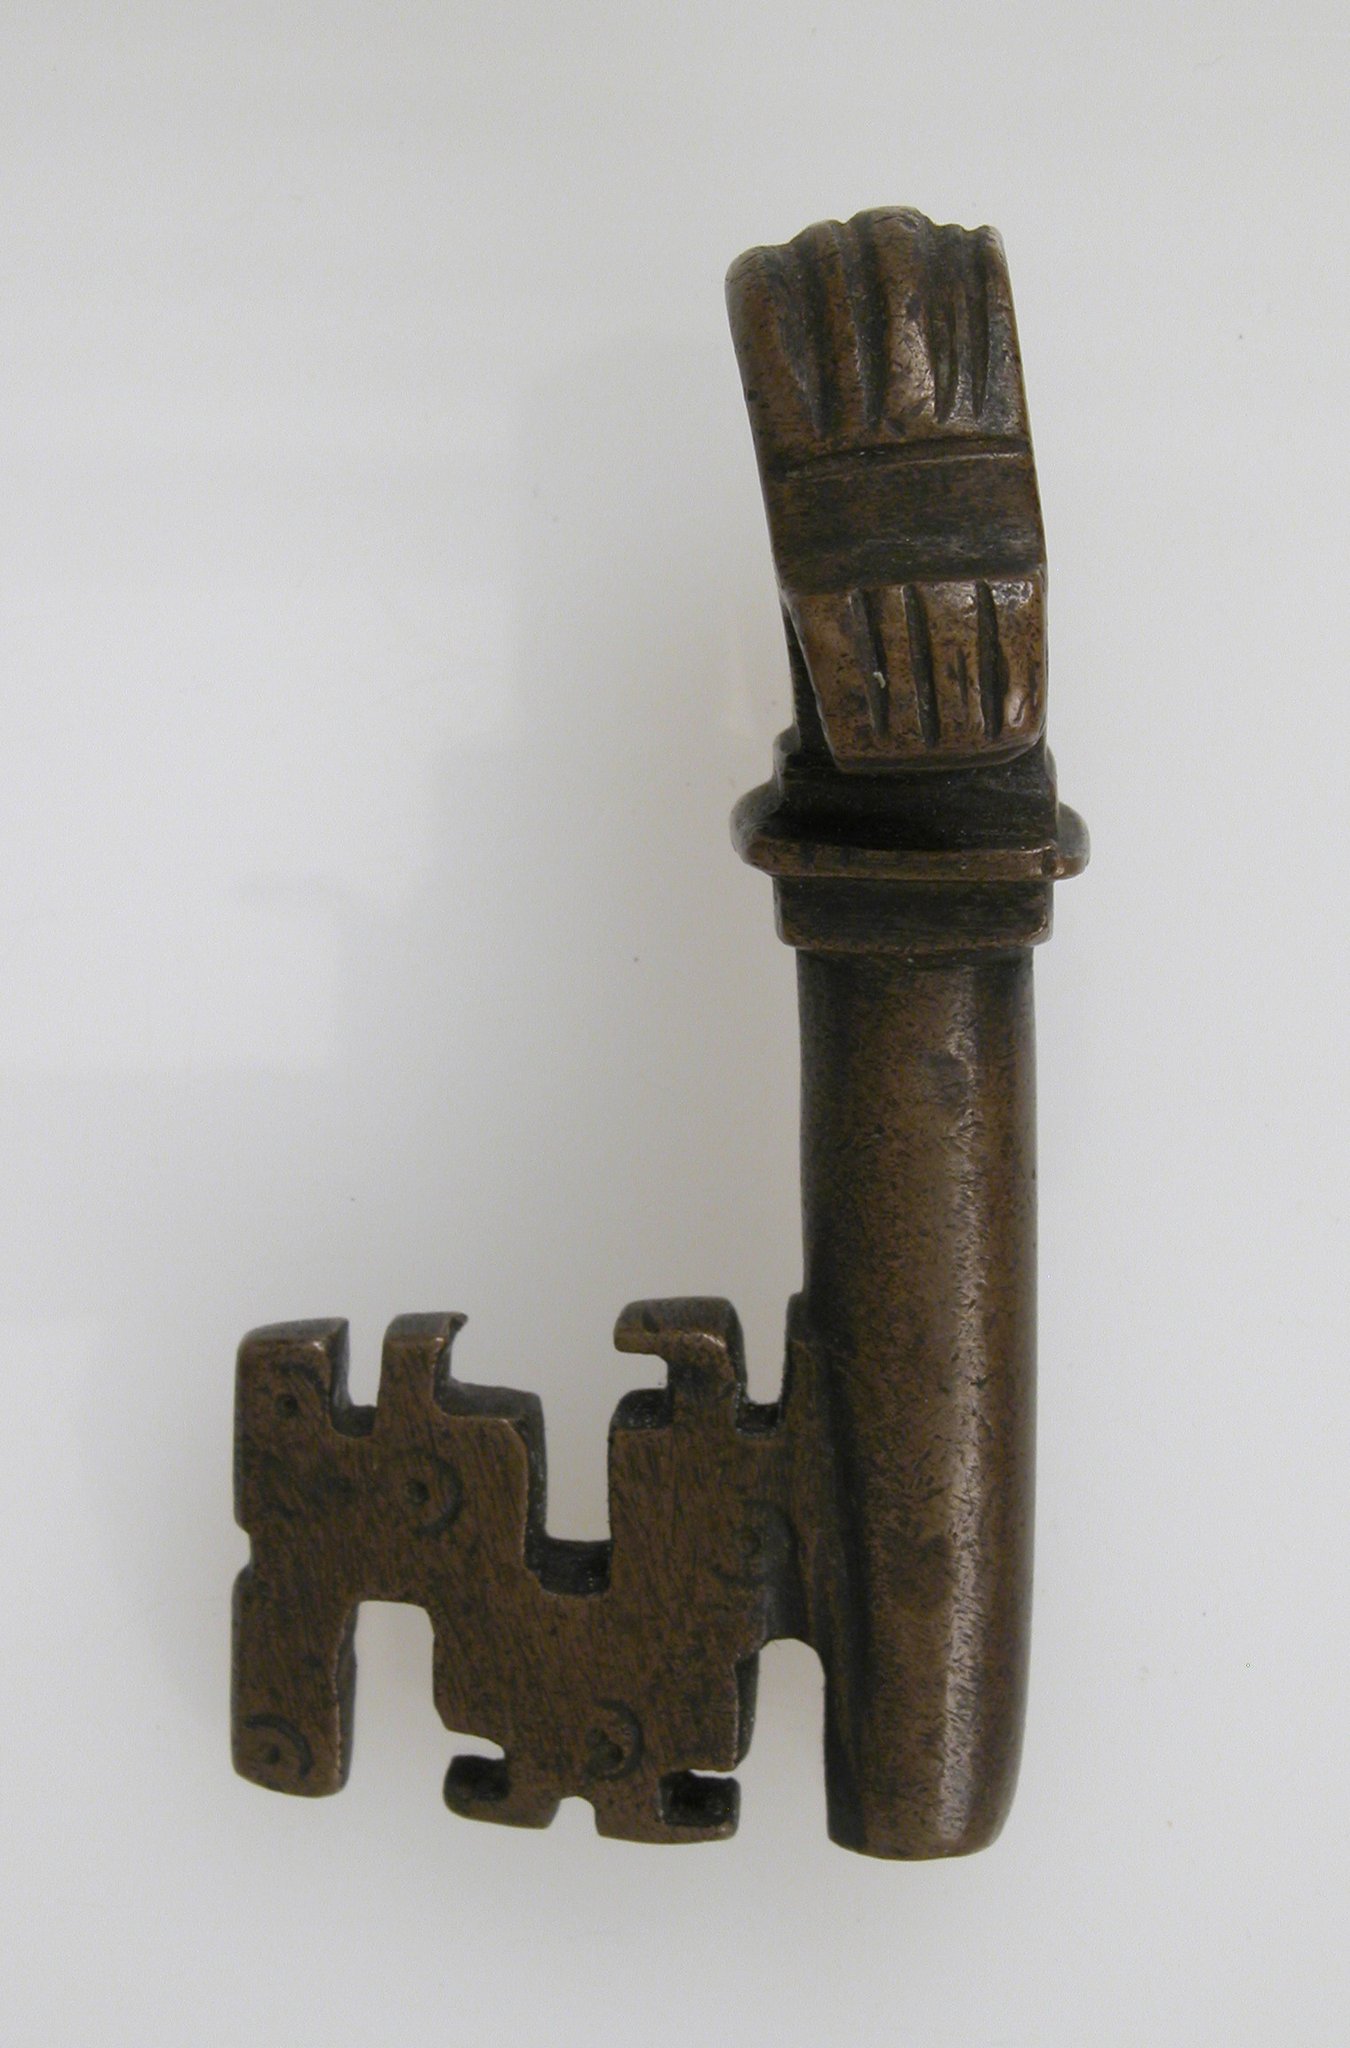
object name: key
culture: roman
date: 1-700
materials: copper alloy